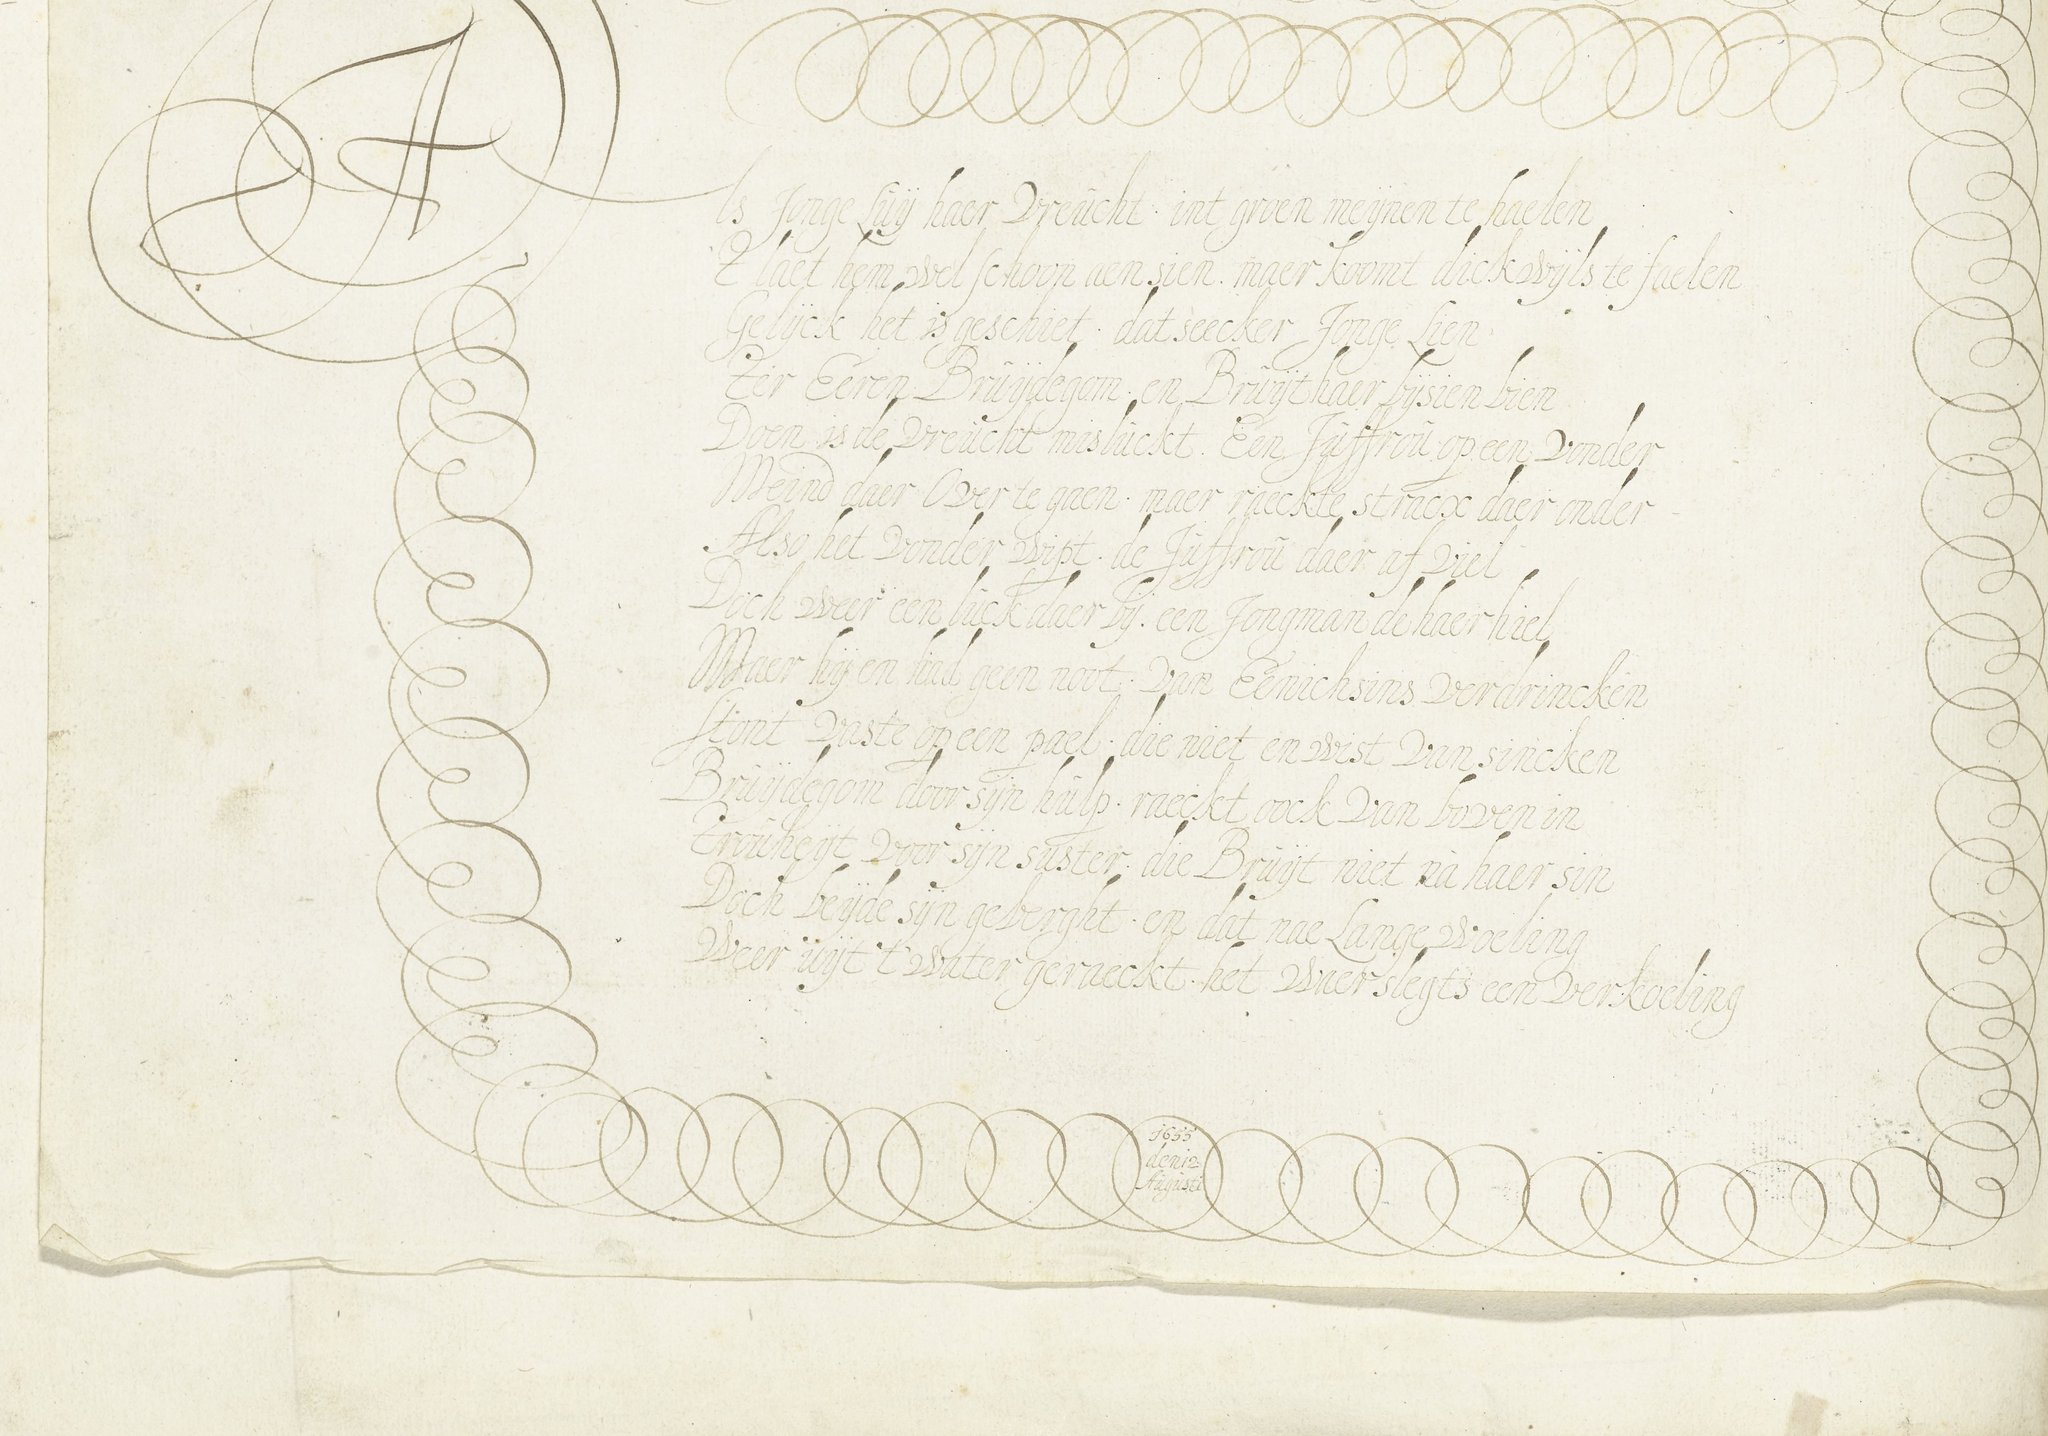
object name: poem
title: Gedicht over een gebroken brug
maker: gesina ter borch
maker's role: draughtsman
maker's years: 1633-1690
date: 1655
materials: ink, paper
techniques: calligraphy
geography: zwolle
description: Gedicht over een gebroken brug, omlijst door kalligrafisch krulwerk.